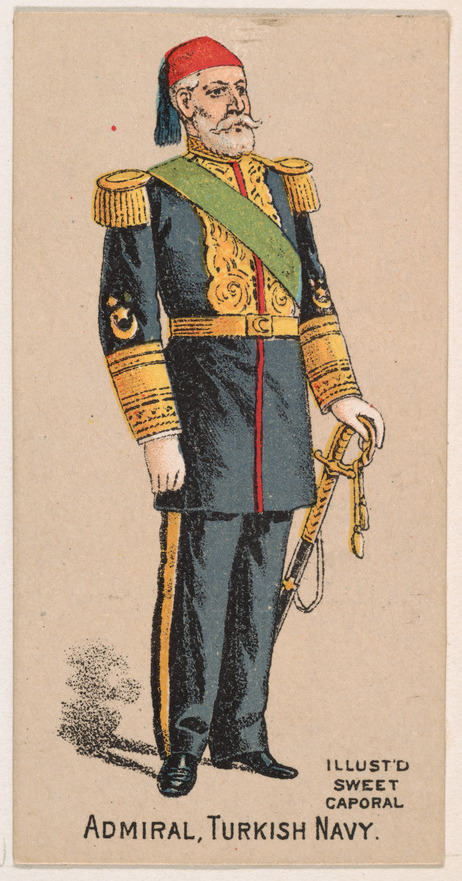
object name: print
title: Admiral, Turkish Navy, from the Military Series (N224) issued by Kinney Tobacco Company to promote Sweet Caporal Cigarettes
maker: kinney brothers tobacco company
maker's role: publisher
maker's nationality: american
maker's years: 1869-2011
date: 1888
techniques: color lithograph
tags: swords,men,admirals